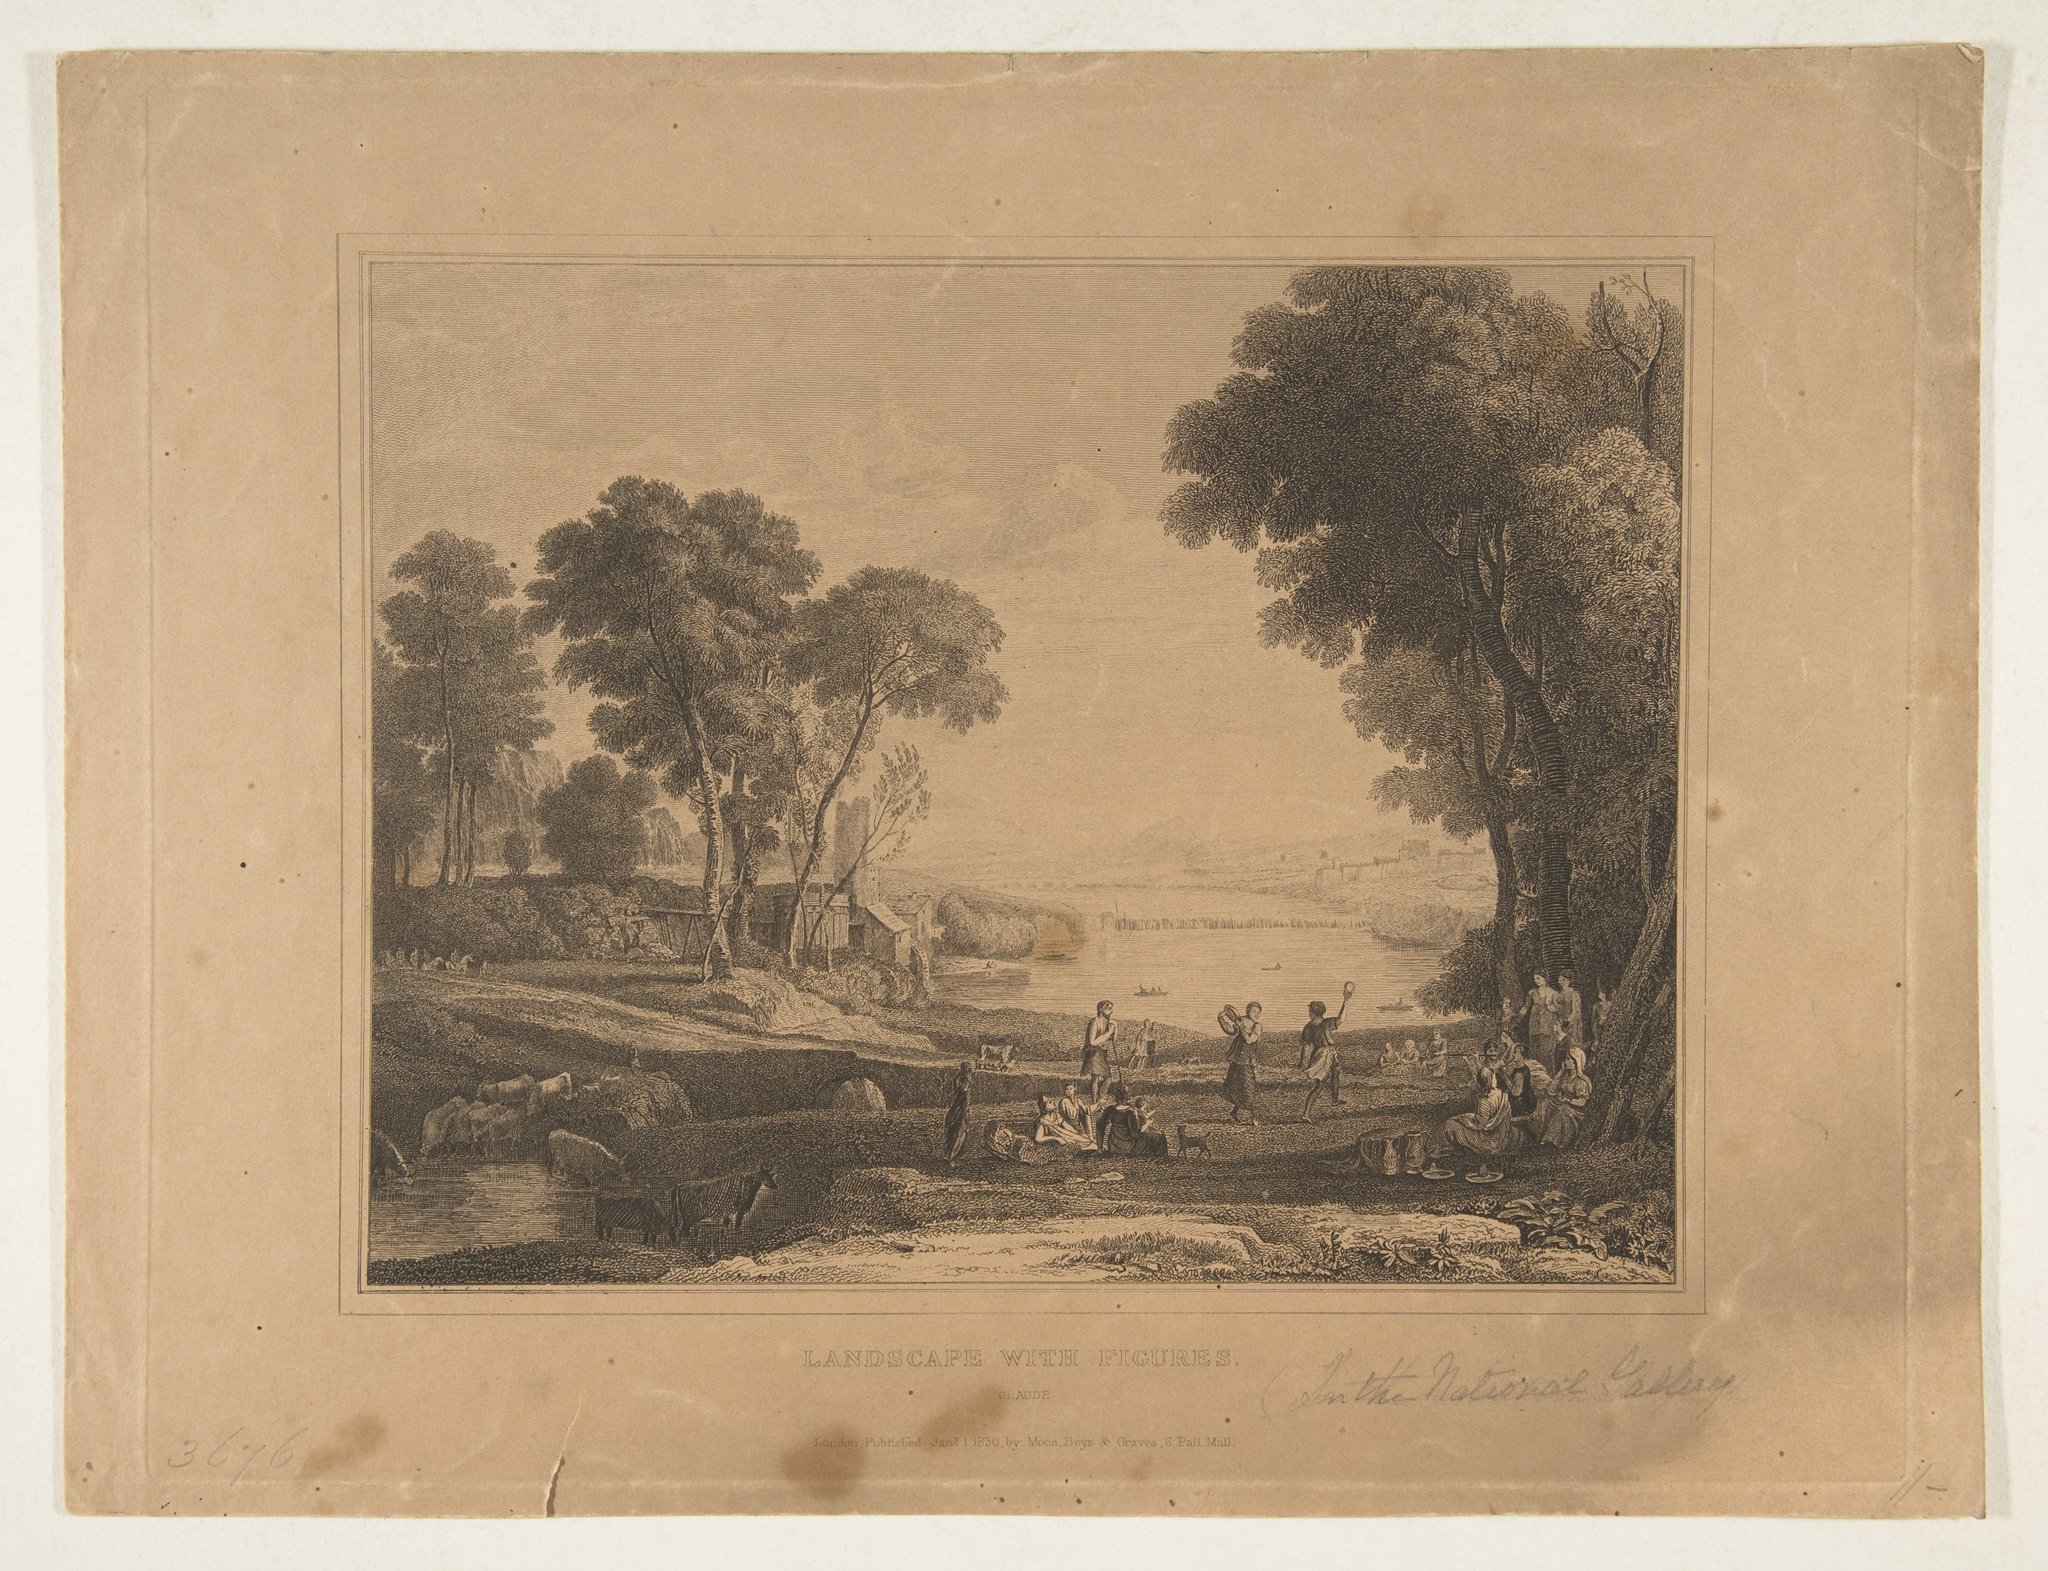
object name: print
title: Landscape with Figures (After The Marriage of Isaac and Rebecca, 1648)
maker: Anonymous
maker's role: artist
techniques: etching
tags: human figures,animals,landscapes,trees